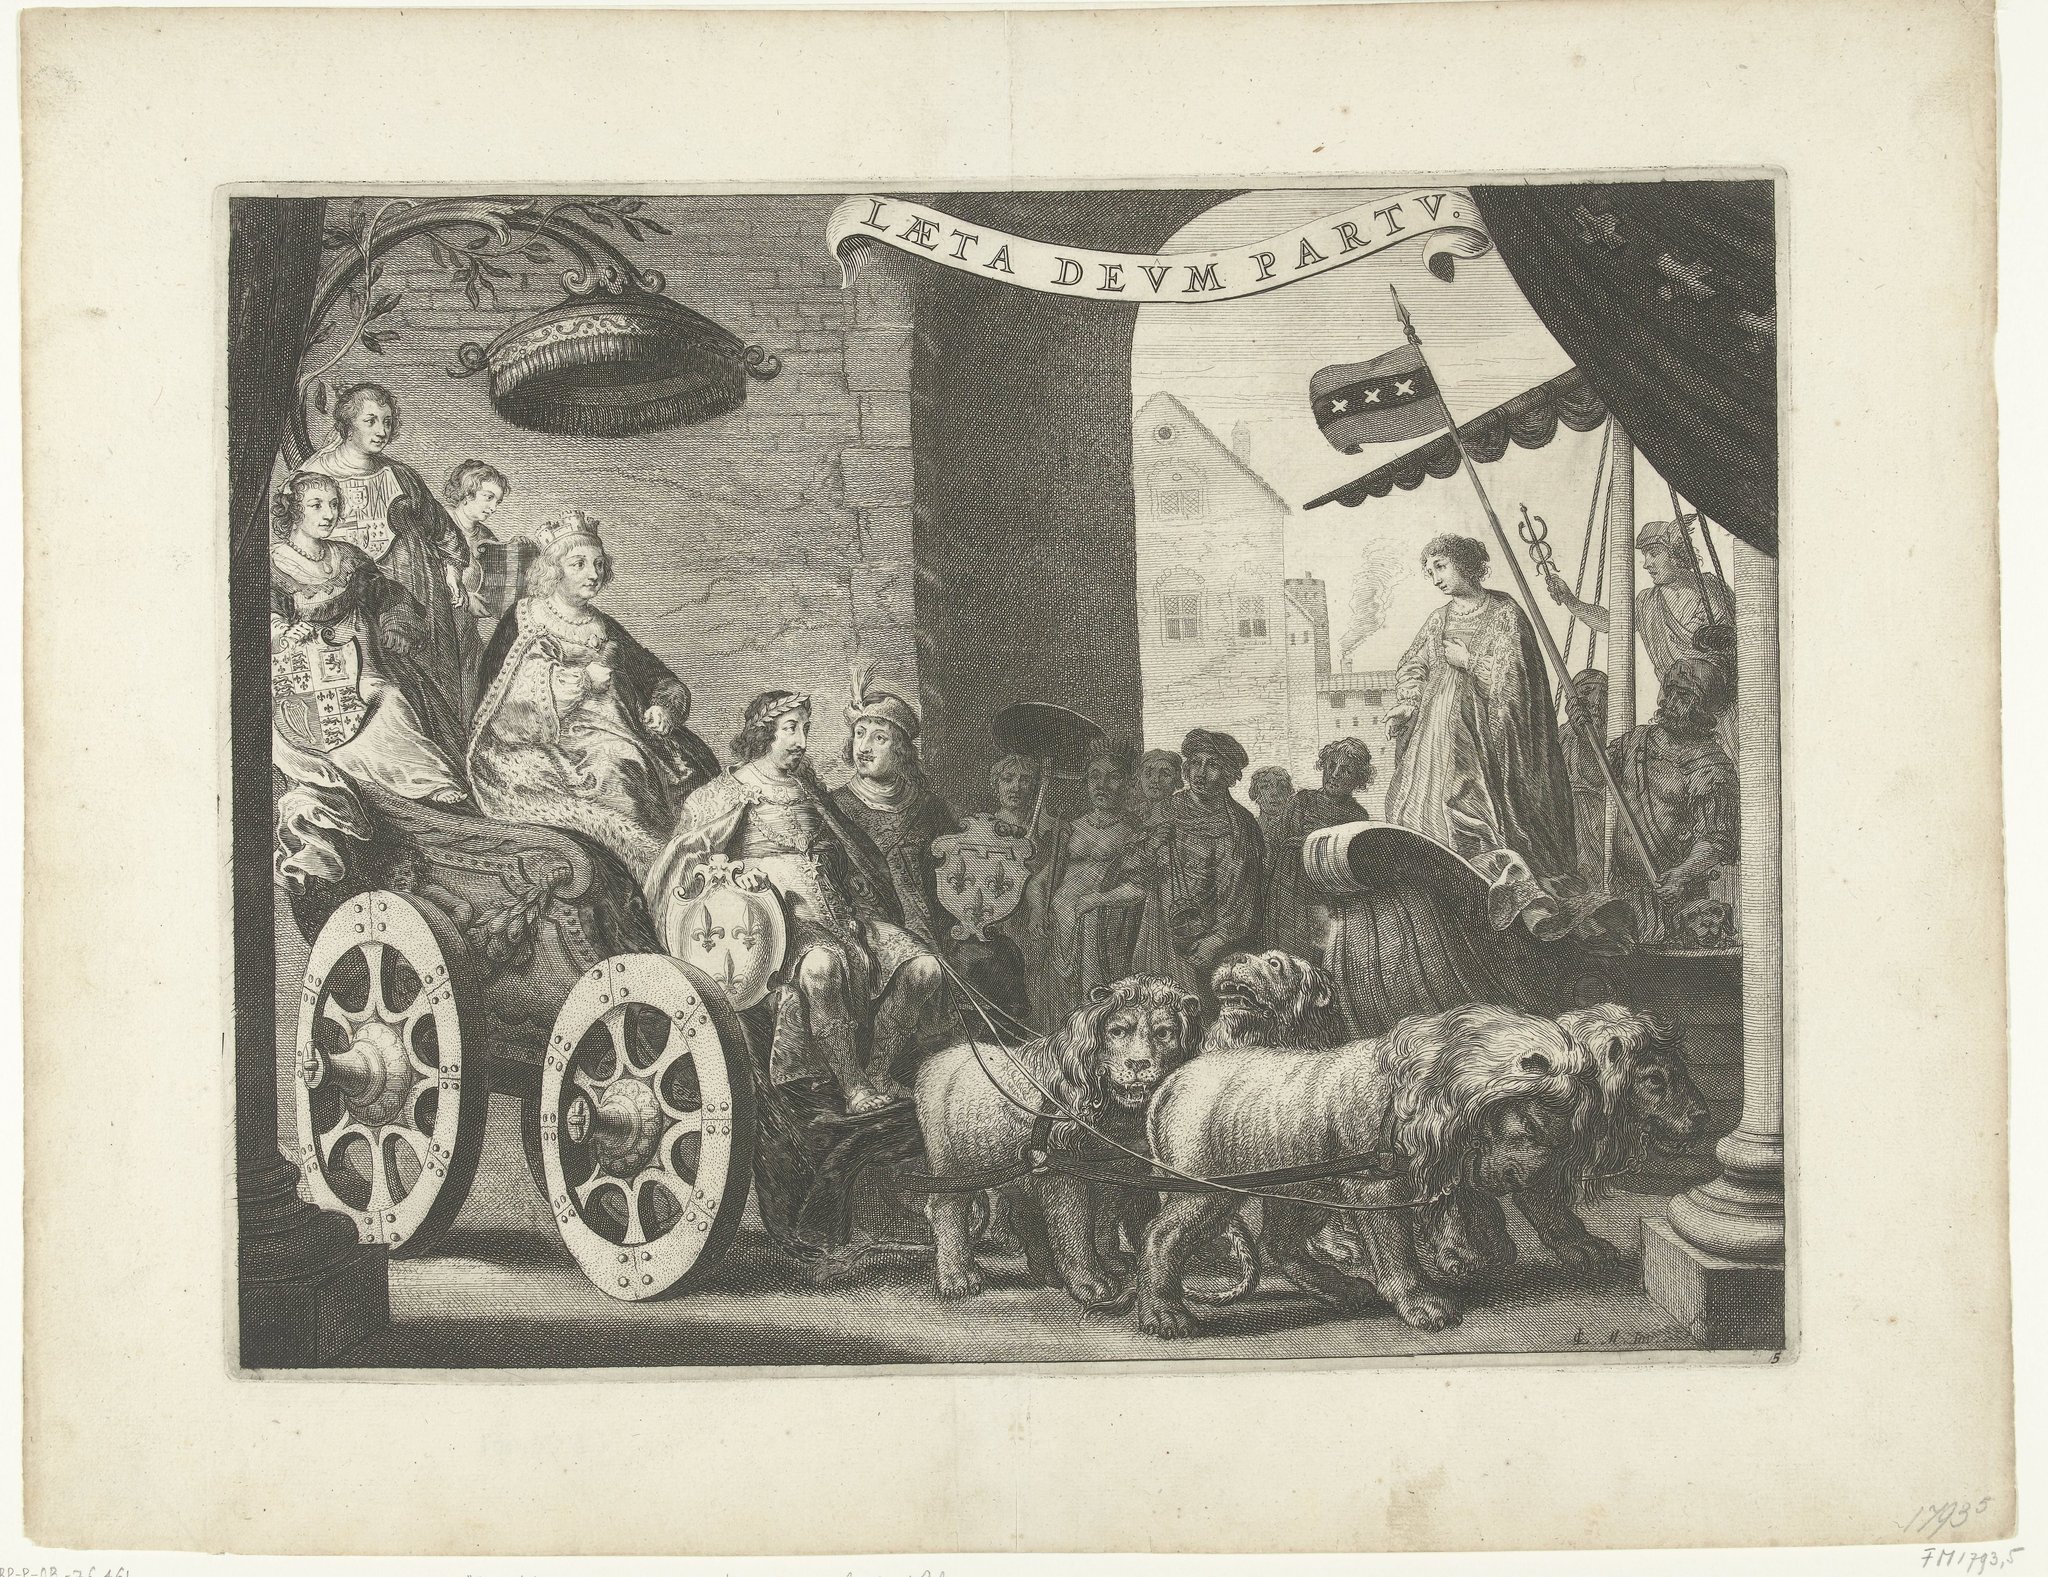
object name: print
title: Maria de' Medici als Cybele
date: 1638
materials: paper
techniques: engraving, etching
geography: amsterdam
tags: cologne, maria de' medici, lodewijk xiii (koning van frankrijk), (story of) mercury (hermes), flag, colours (as symbol of the state, etc.) (+ city; municipal), triumphal entry and public reception, pageant, 'entrée solennelle', 'joyeuse entrée', cities represented allegorically or symbolically, continents represented allegorically, armorial bearing, heraldry, specific aspects, allegorical aspects of cybele; cybele as patroness, amsterdam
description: Prent ook gebruikt in:* Baerle, Caspar van. Medicea hospes, sive descriptio publicae gratulationis, qua Serenissimam, Augustissimamque Reginam, Mariam de Medicis (…). Amsterdam: Johannes en Cornelis Willemsz. Blaeu, 1638. En in: Baerle, Caspar van. Marie de Medicis, entrant dans Amsterdam : ou, histoire de la reception faicte à la Reyne Mere du Roy tres-Chrestien (…). Amsterdam: Johannes en Cornelis Willemsz. Blaeu, 1638. En in: Baerle, Caspar van en Joost van den Vondel. Blyde inkomst der allerdoorluchtighste koninginne, Maria de Medicis t' Amsterdam. Vertaelt uit het Latijn (…). Amsterdam: Johannes en Cornelis Willemsz. Blaeu, 1639. * Doorgaans zijn de prenten in de bovengenoemde publicaties rechtsonder genummerd (van de huidige prent is dat de derde bekende staat). Maar er zijn ook exemplaren waarin eerdere, ongenummerde, staten van de prenten (van de huidige prent de eerste en tweede bekende staat) zijn ingebonden.